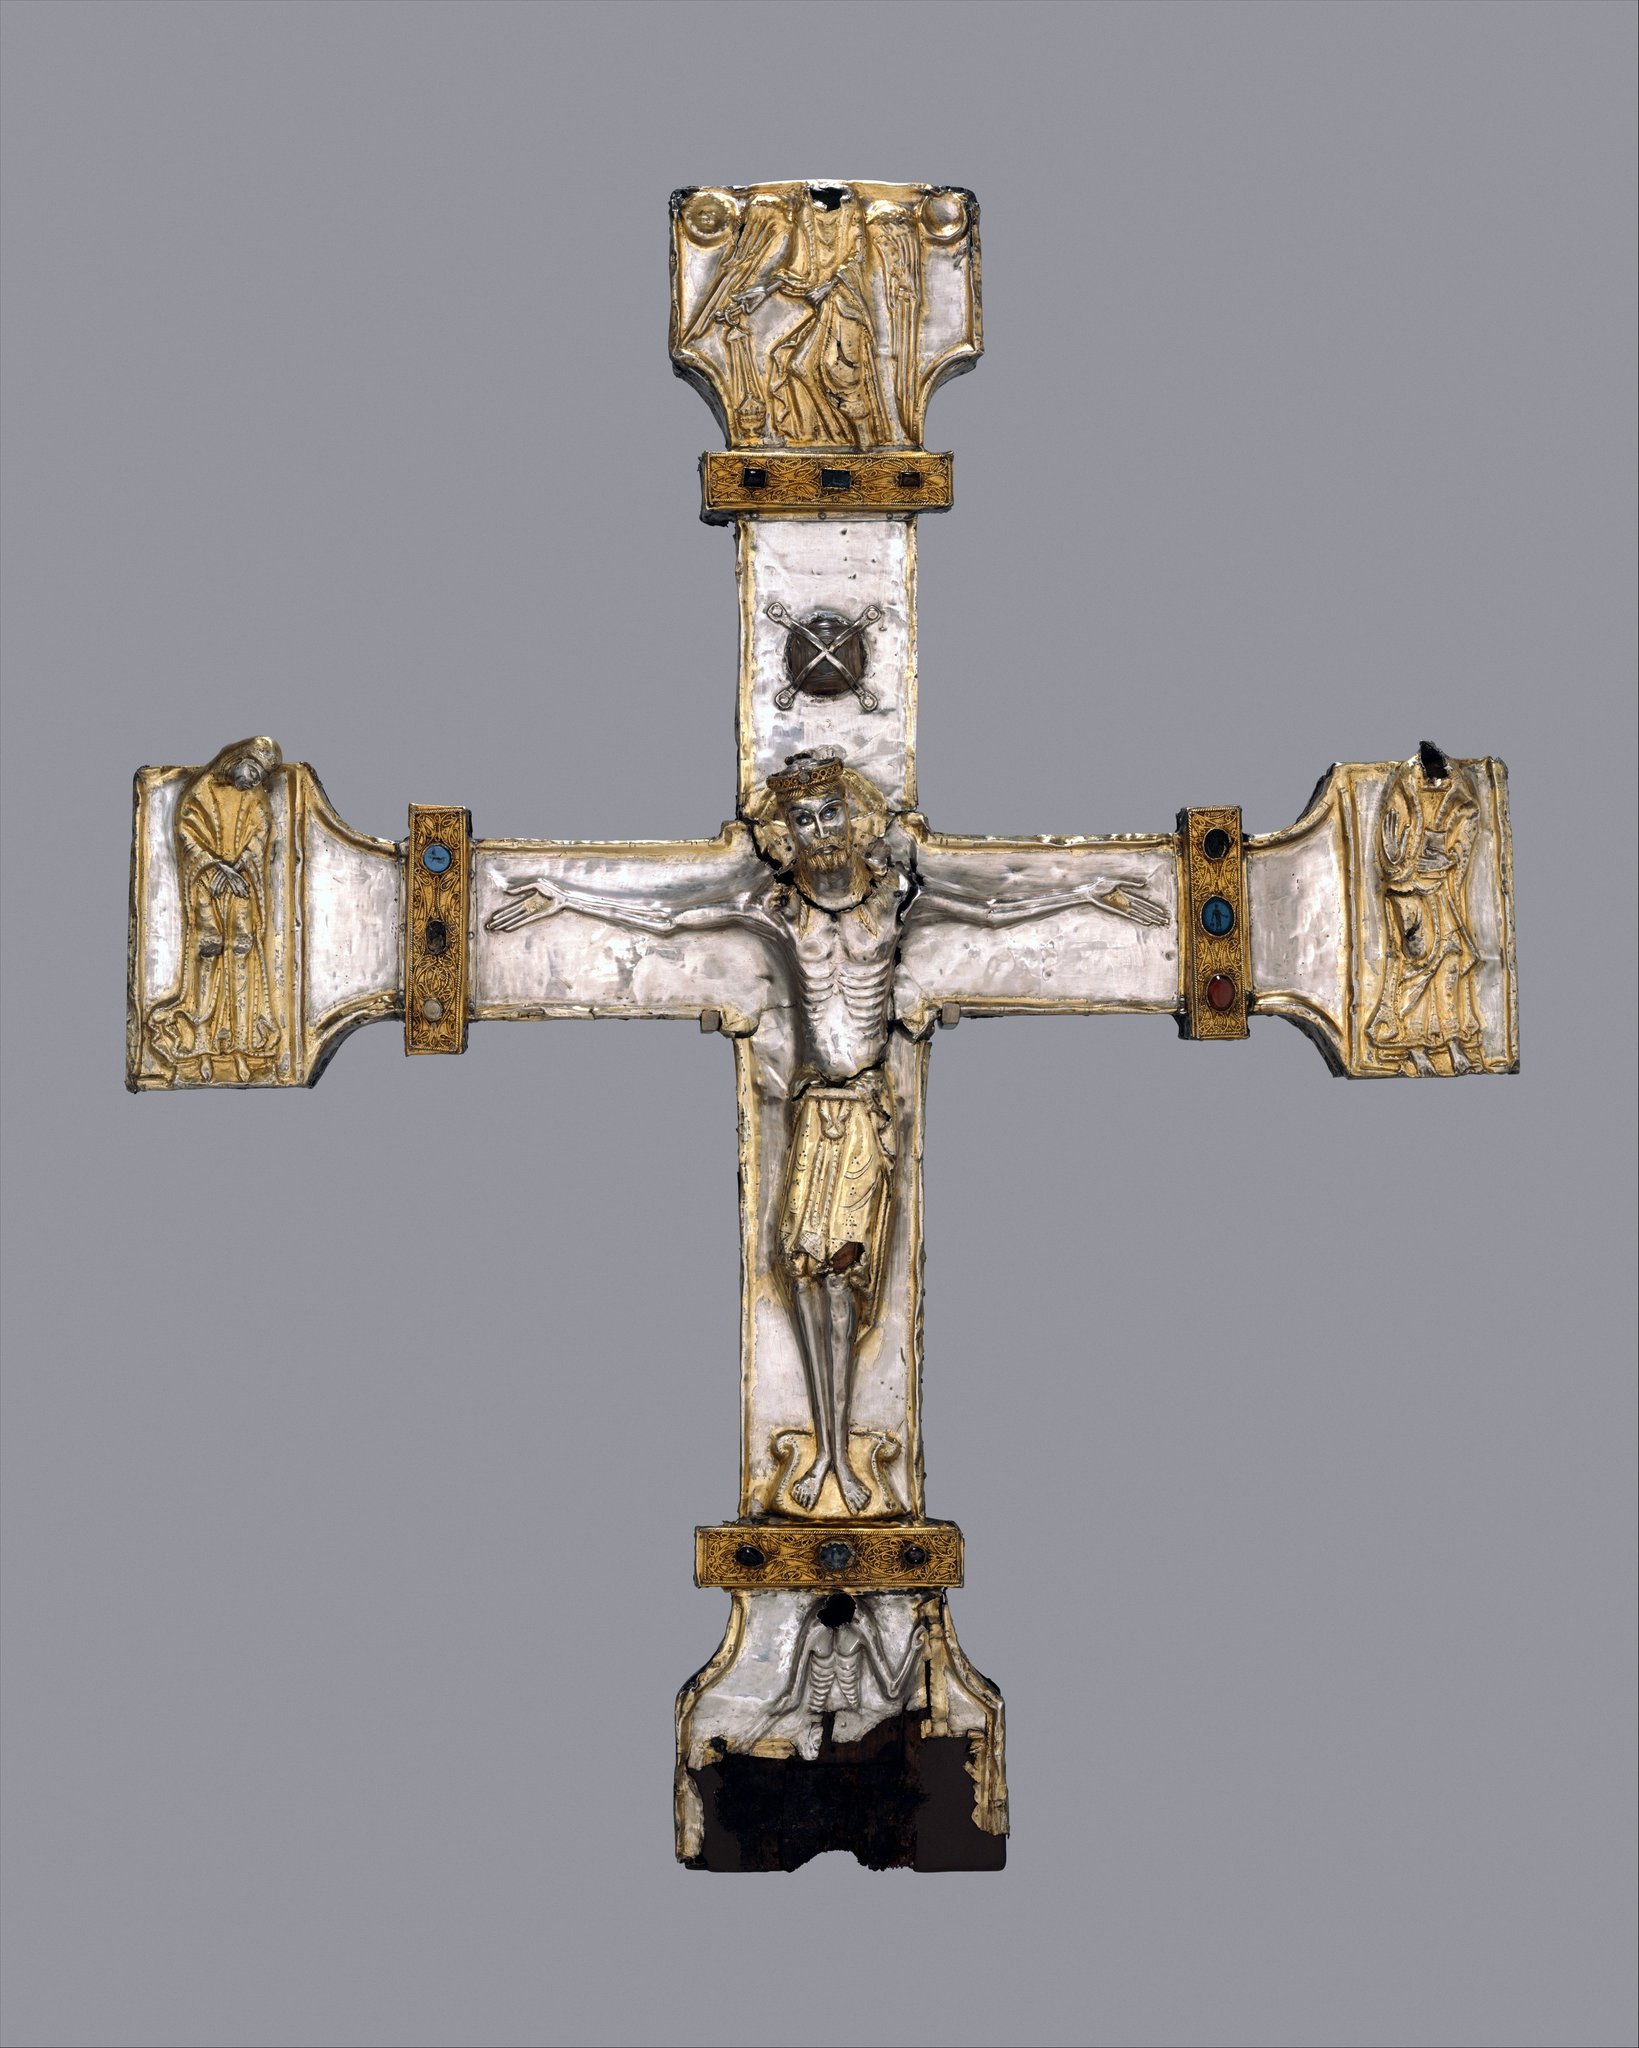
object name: cross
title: Processional Cross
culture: spanish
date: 1150-1175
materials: gilt, silver, wood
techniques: carving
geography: spain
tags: angels,christ,virgin mary,cross,adam,crucifixion